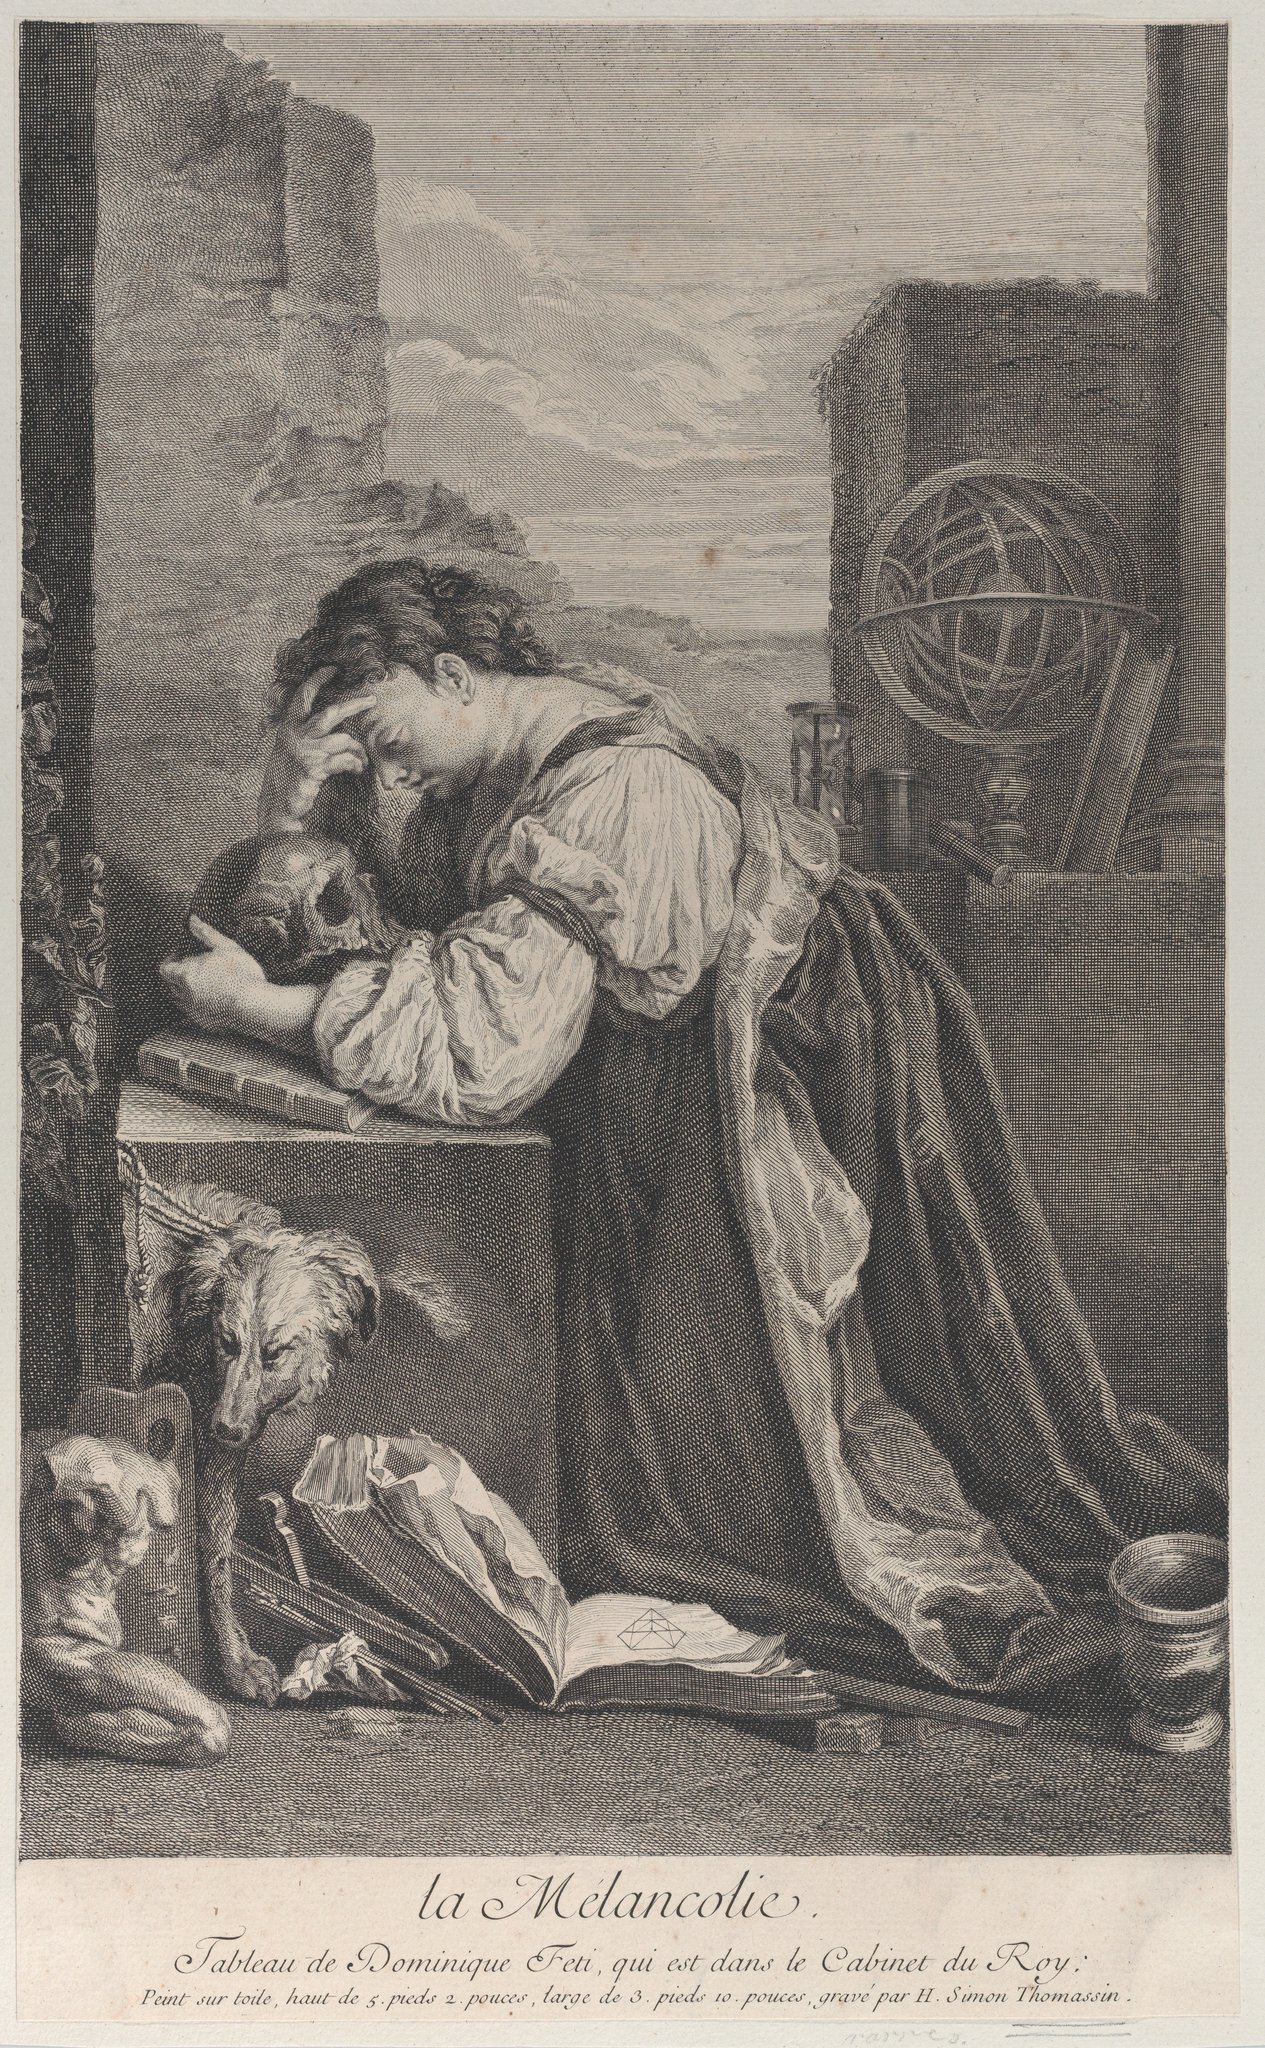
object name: print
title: Allegory on Melancholy, with a woman kneeling towards the left holding a skull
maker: henri simon thomassin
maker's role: artist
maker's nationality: french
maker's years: 1687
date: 1729-1740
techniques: engraving, etching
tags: skulls,women,dogs,allegory